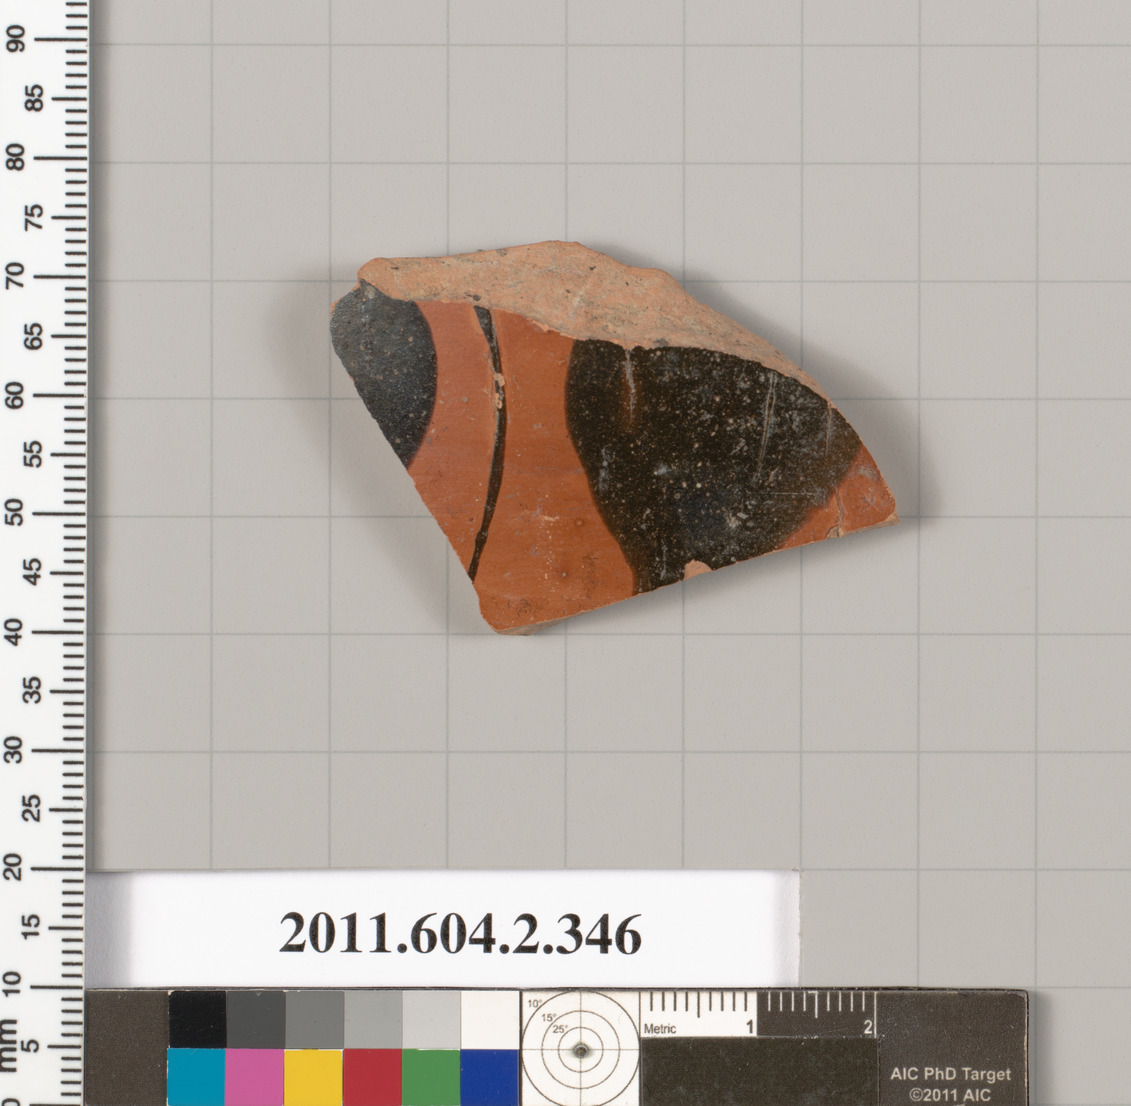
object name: column krater fragment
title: Terracotta fragment of a column-krater (bowl for mixing wine and water)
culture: greek, attic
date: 475-440 BCE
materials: terracotta